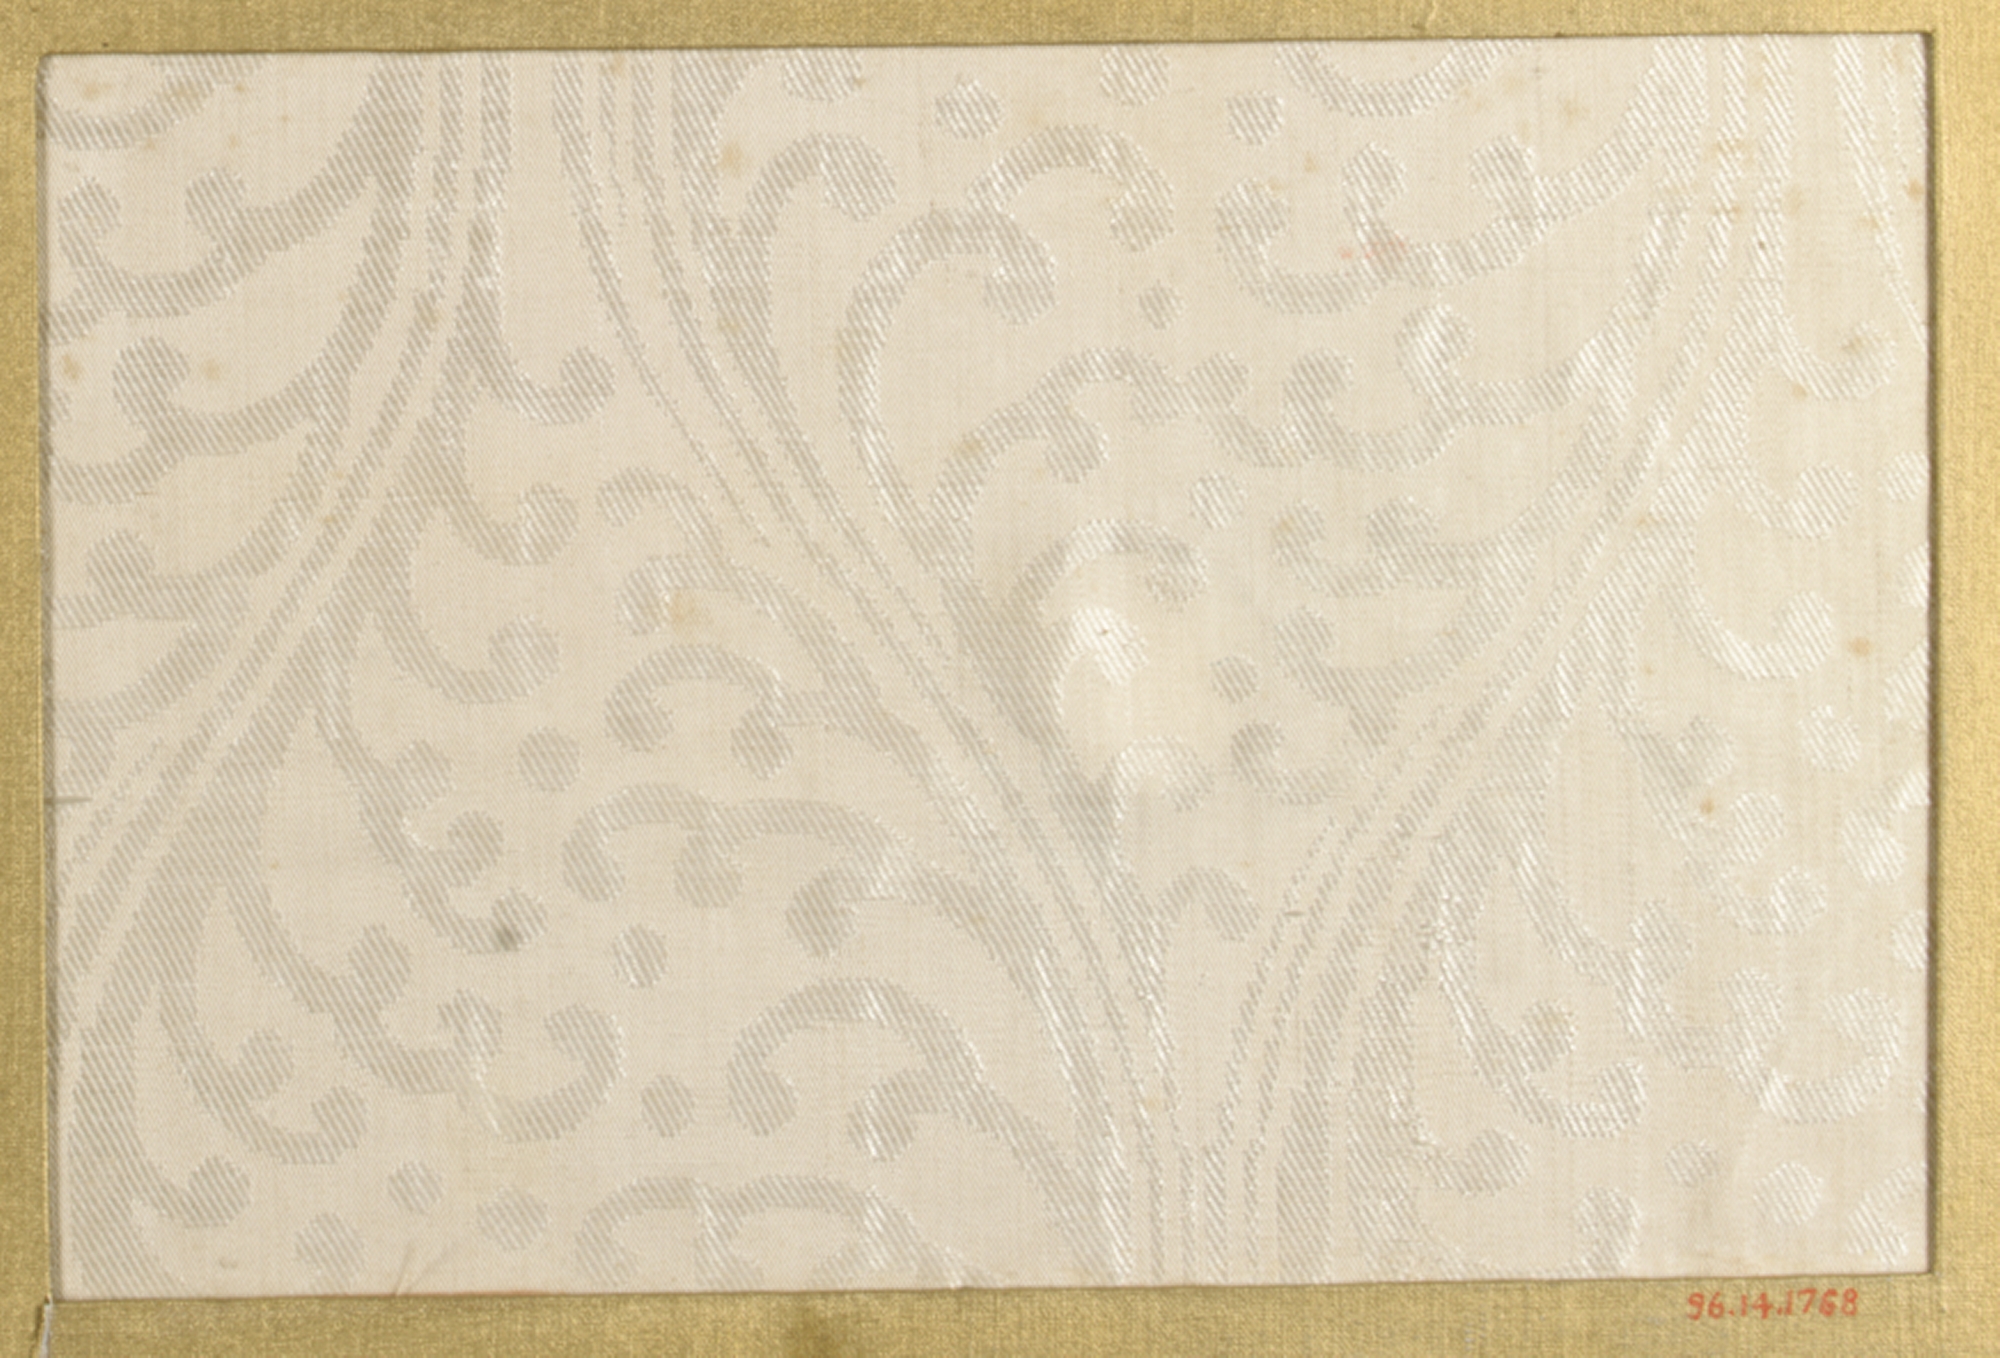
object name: piece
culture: japanese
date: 1701-1900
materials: silk